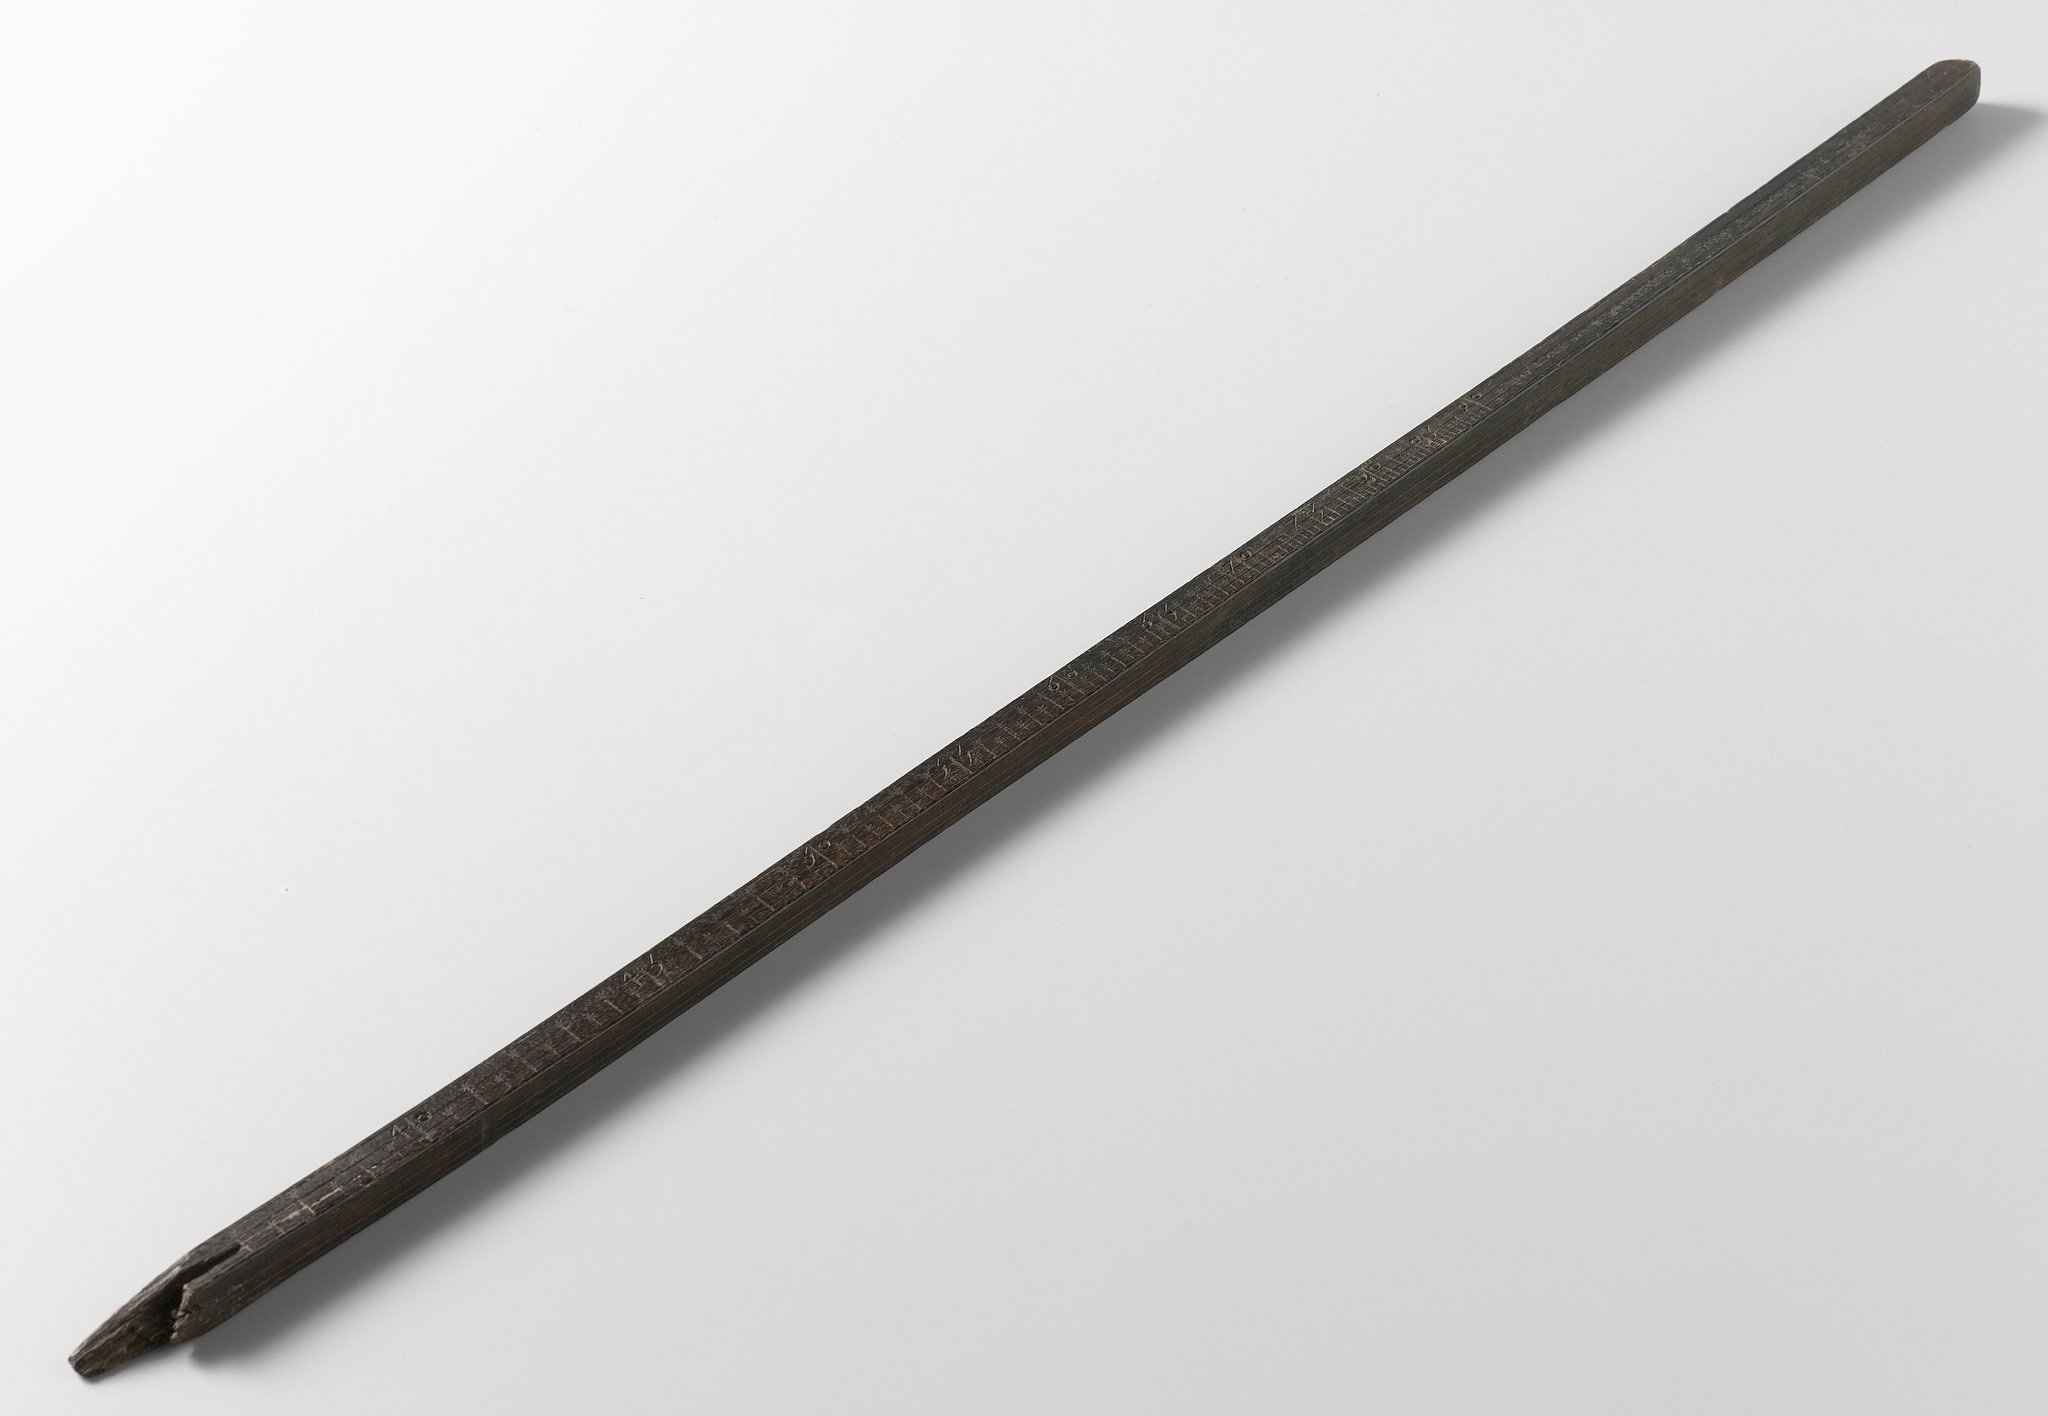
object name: graadstok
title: Navigation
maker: claes andrieszoon goutum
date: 1590-1596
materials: wood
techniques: printing, cutting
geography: amsterdam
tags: willem barendsz., amsterdam, jacob van heemskerck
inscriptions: inscription: ‘Dit is die son sijde Claes Andriesson Goutom [of ... Andriessen Goutijk]’, inscription: ‘Dit is die Noersters siede Gout om deught’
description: To determine the ship’s position and chart its course, the captain had an entire arsenal of instruments at his disposal. Among the items found on Nova Zembla are an astrolabium catholicum (universal astrolabe), a fragment of a copper sounding line, a cross staff, a sextant and a chart compass.